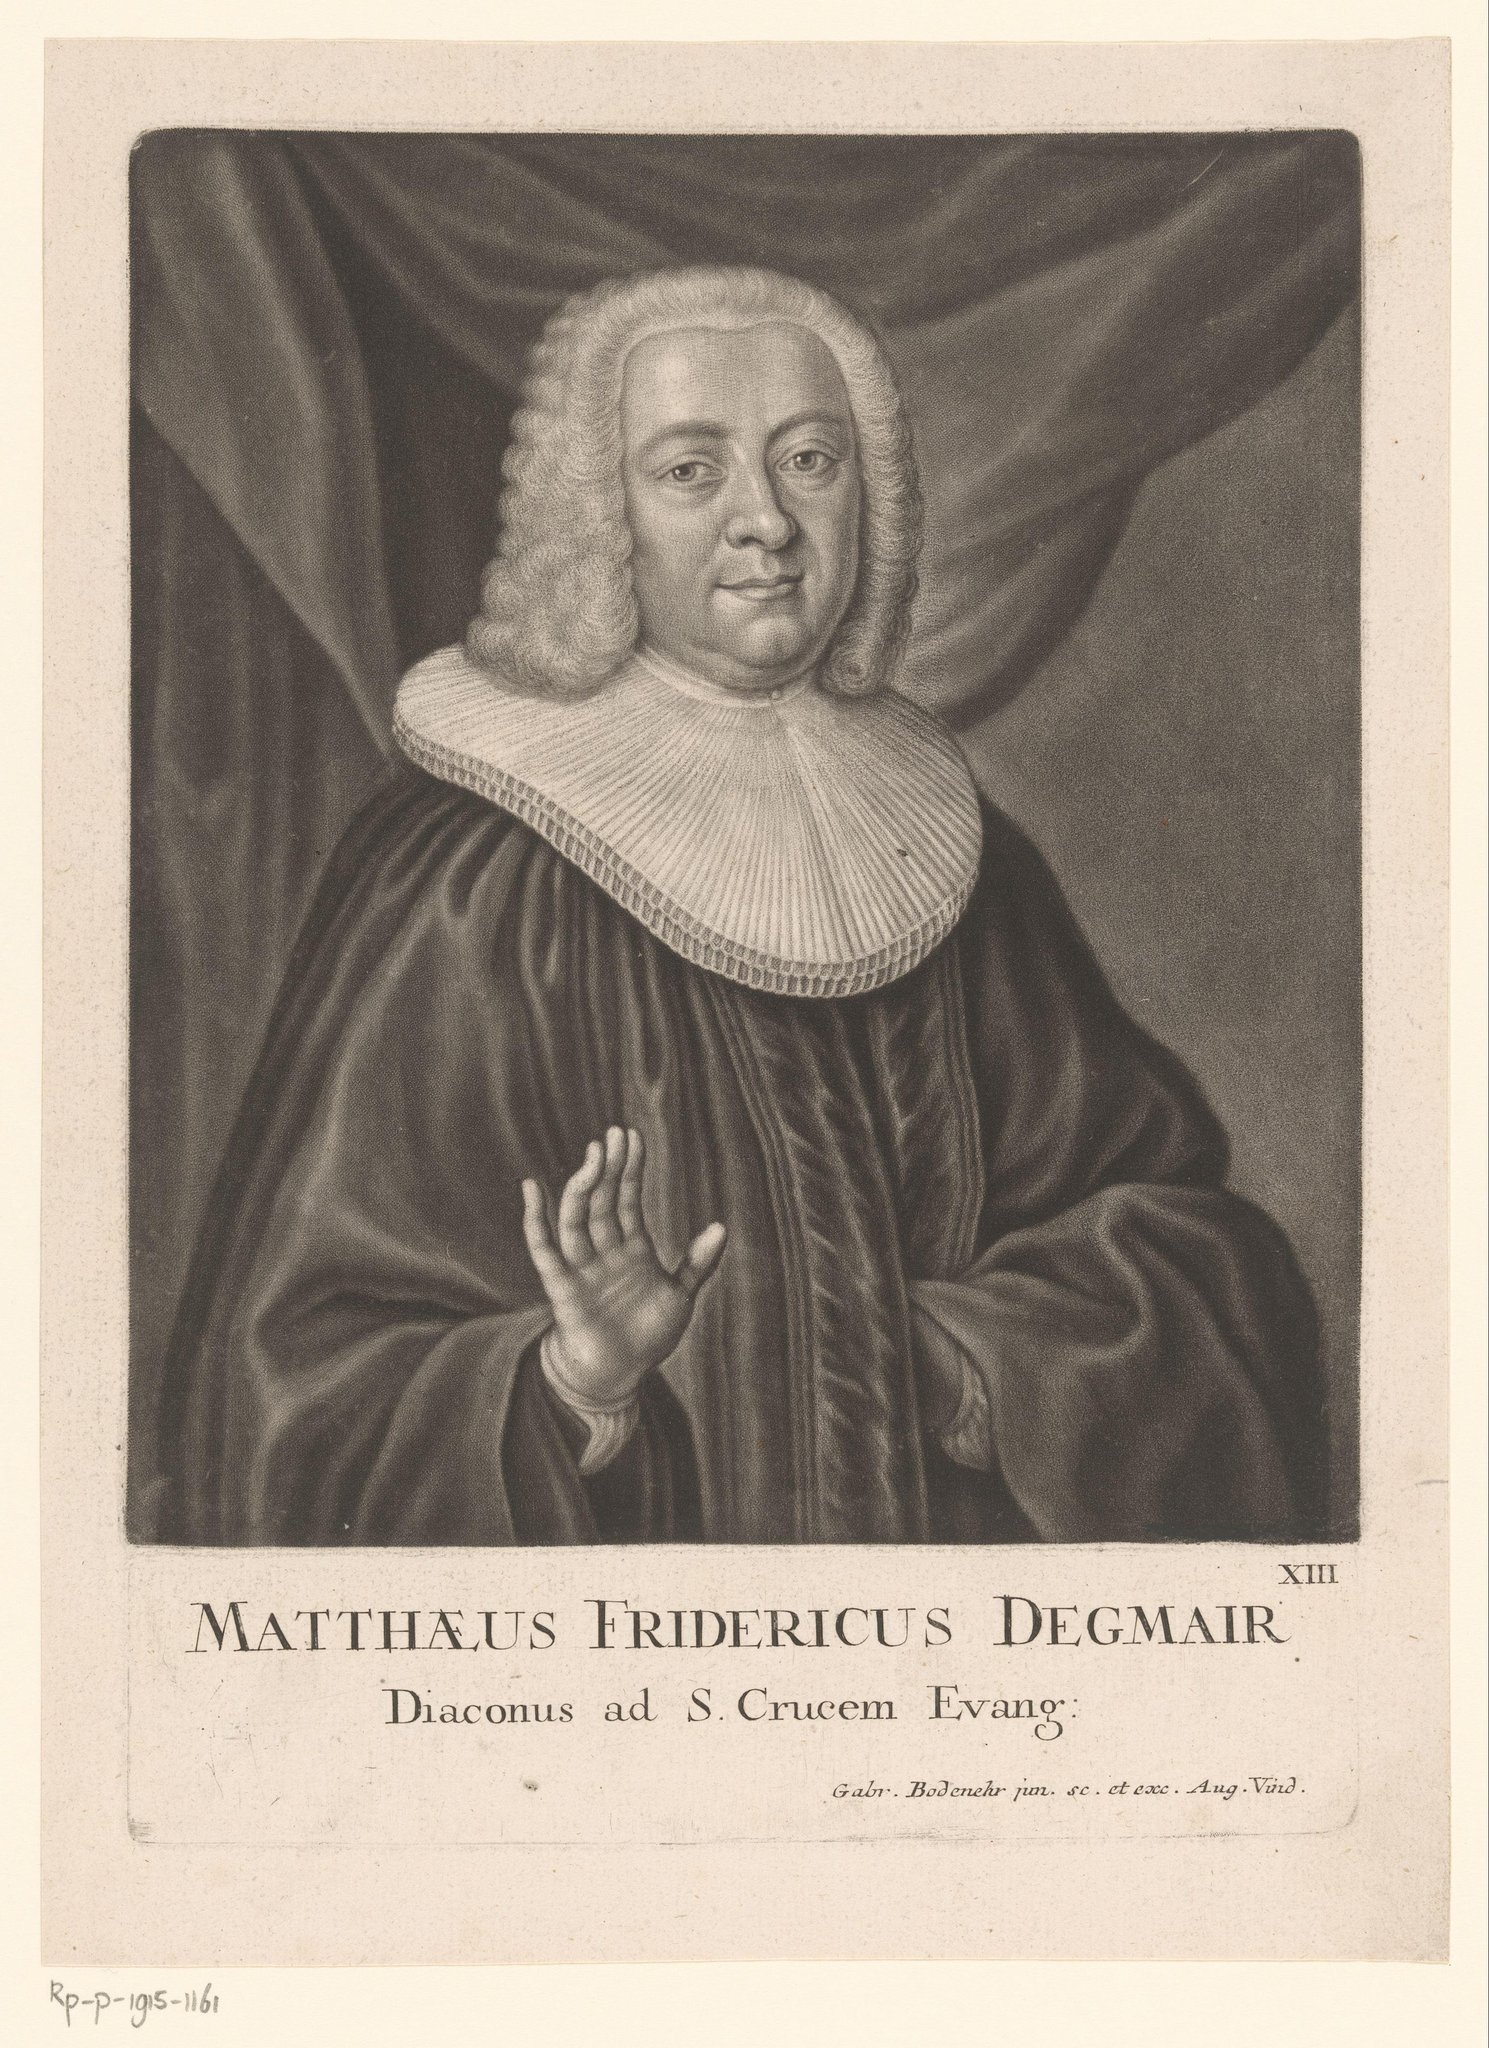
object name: print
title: Portret van Matthäus Friedrich Degmair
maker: gabriel bodenehr (ii)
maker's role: print maker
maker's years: 1705-1792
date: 1718-1781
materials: paper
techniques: mezzotint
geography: augsburg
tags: historical persons, deacon (roman catholic)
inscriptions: collector's mark: Lugt 2228